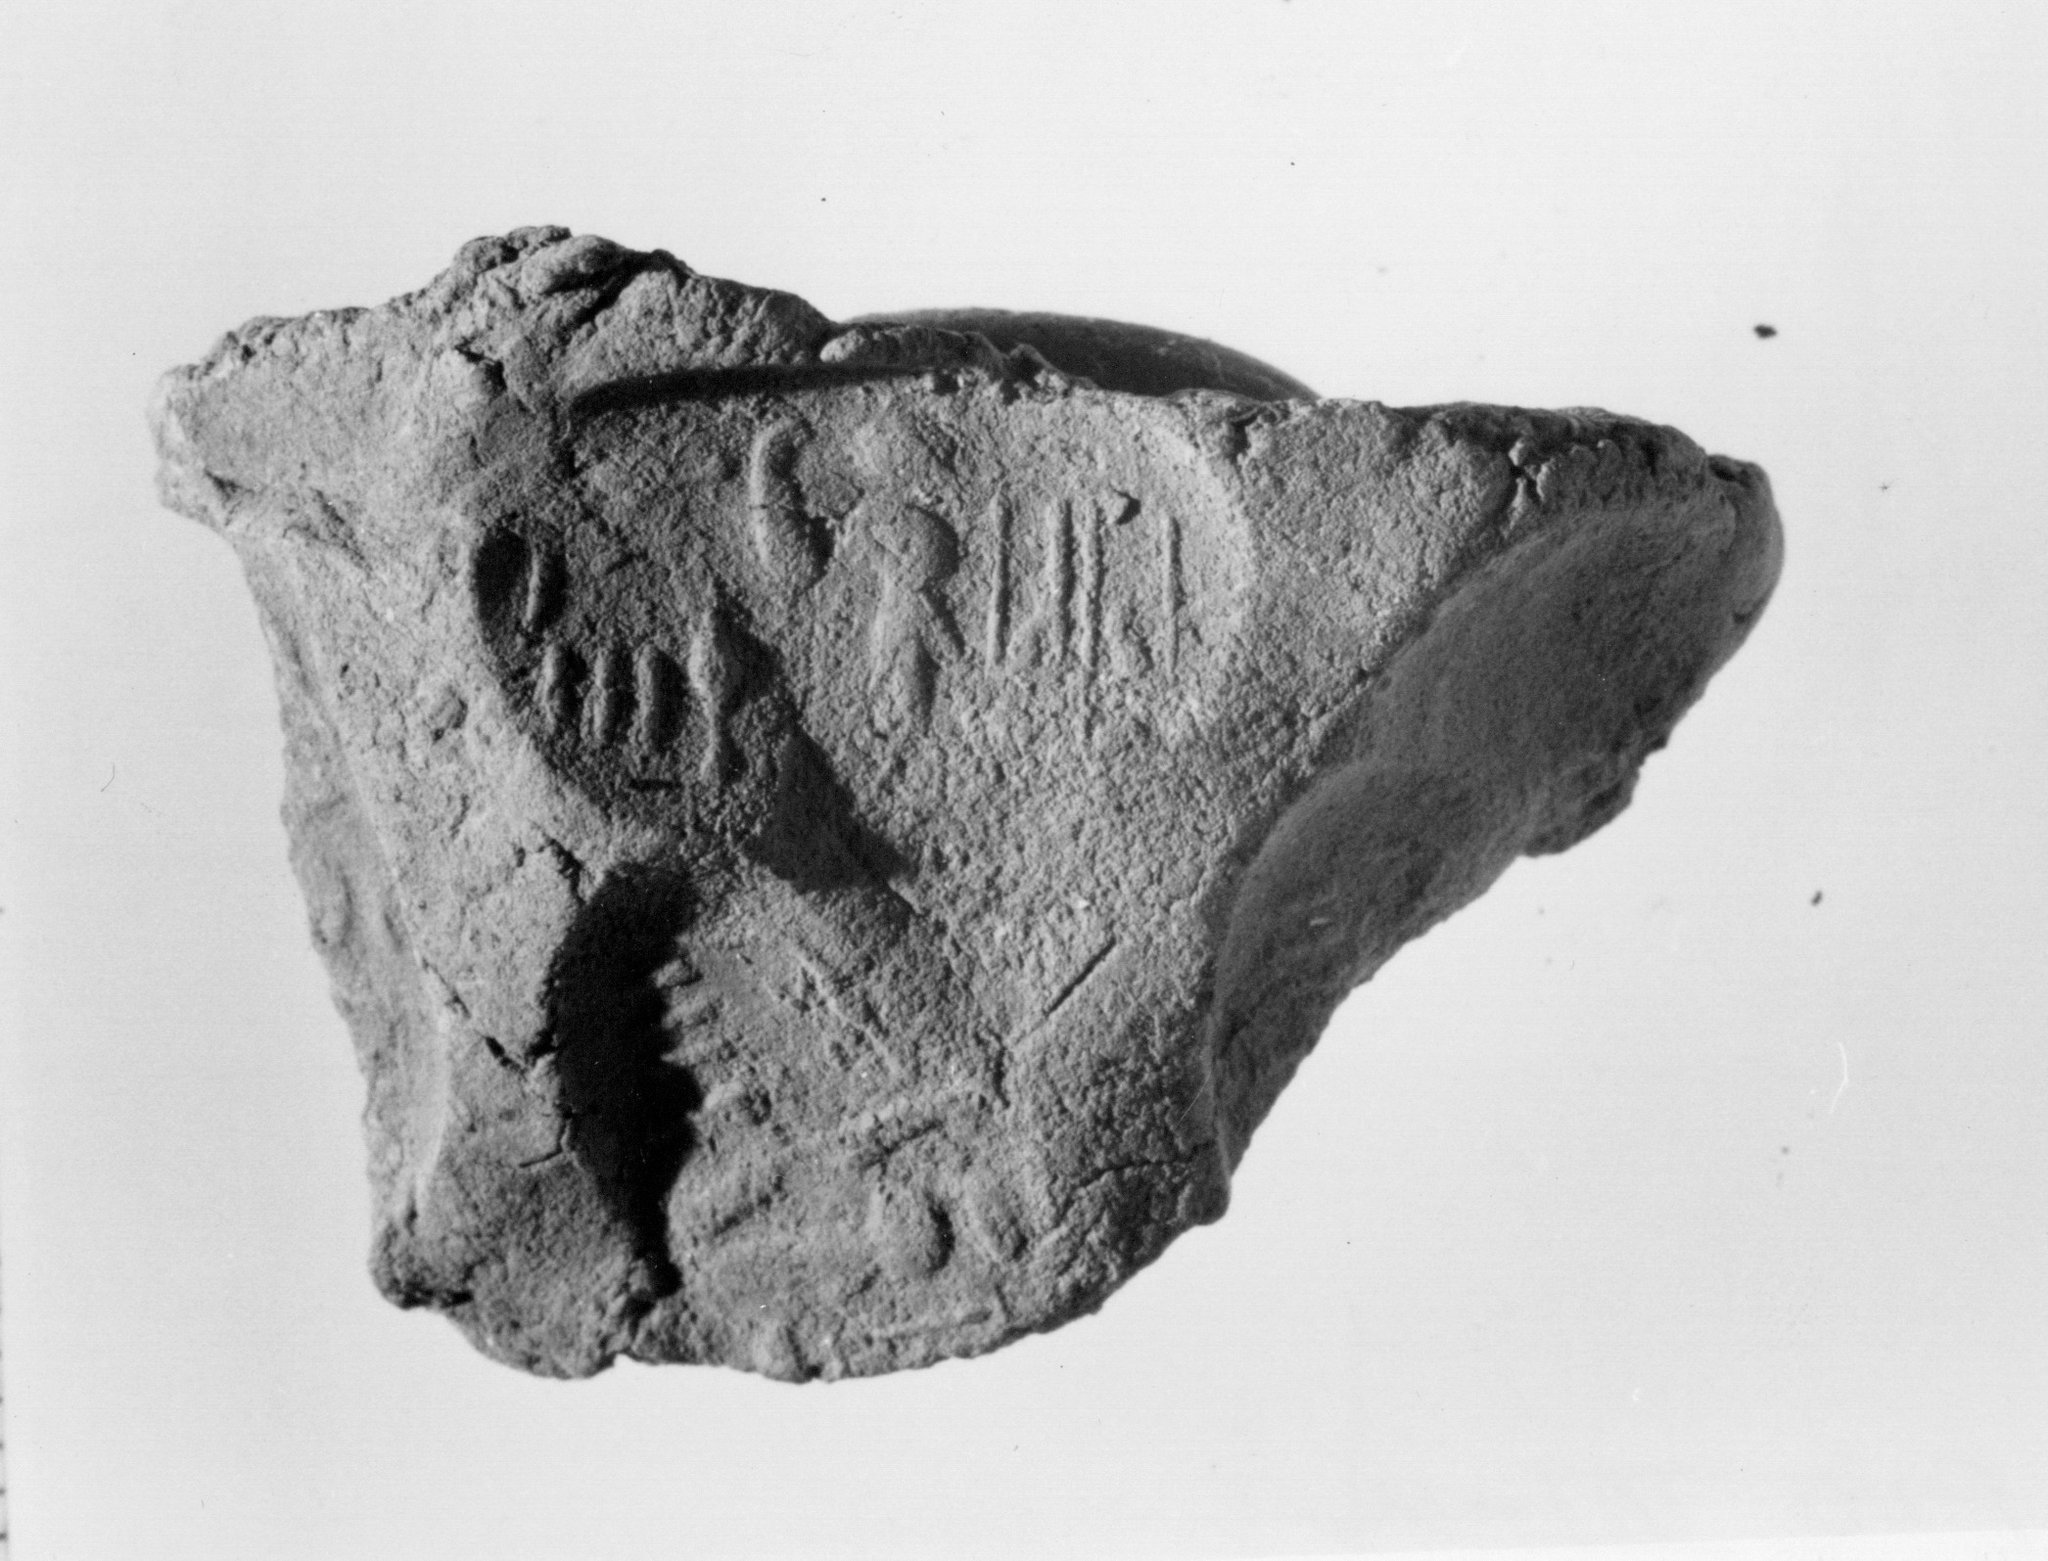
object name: sealing, nebmaatre, amenhotep iii, heb sed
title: Document Sealing With the Throne Name of Amenhotep III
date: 1390-1352 BCE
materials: mud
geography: egypt